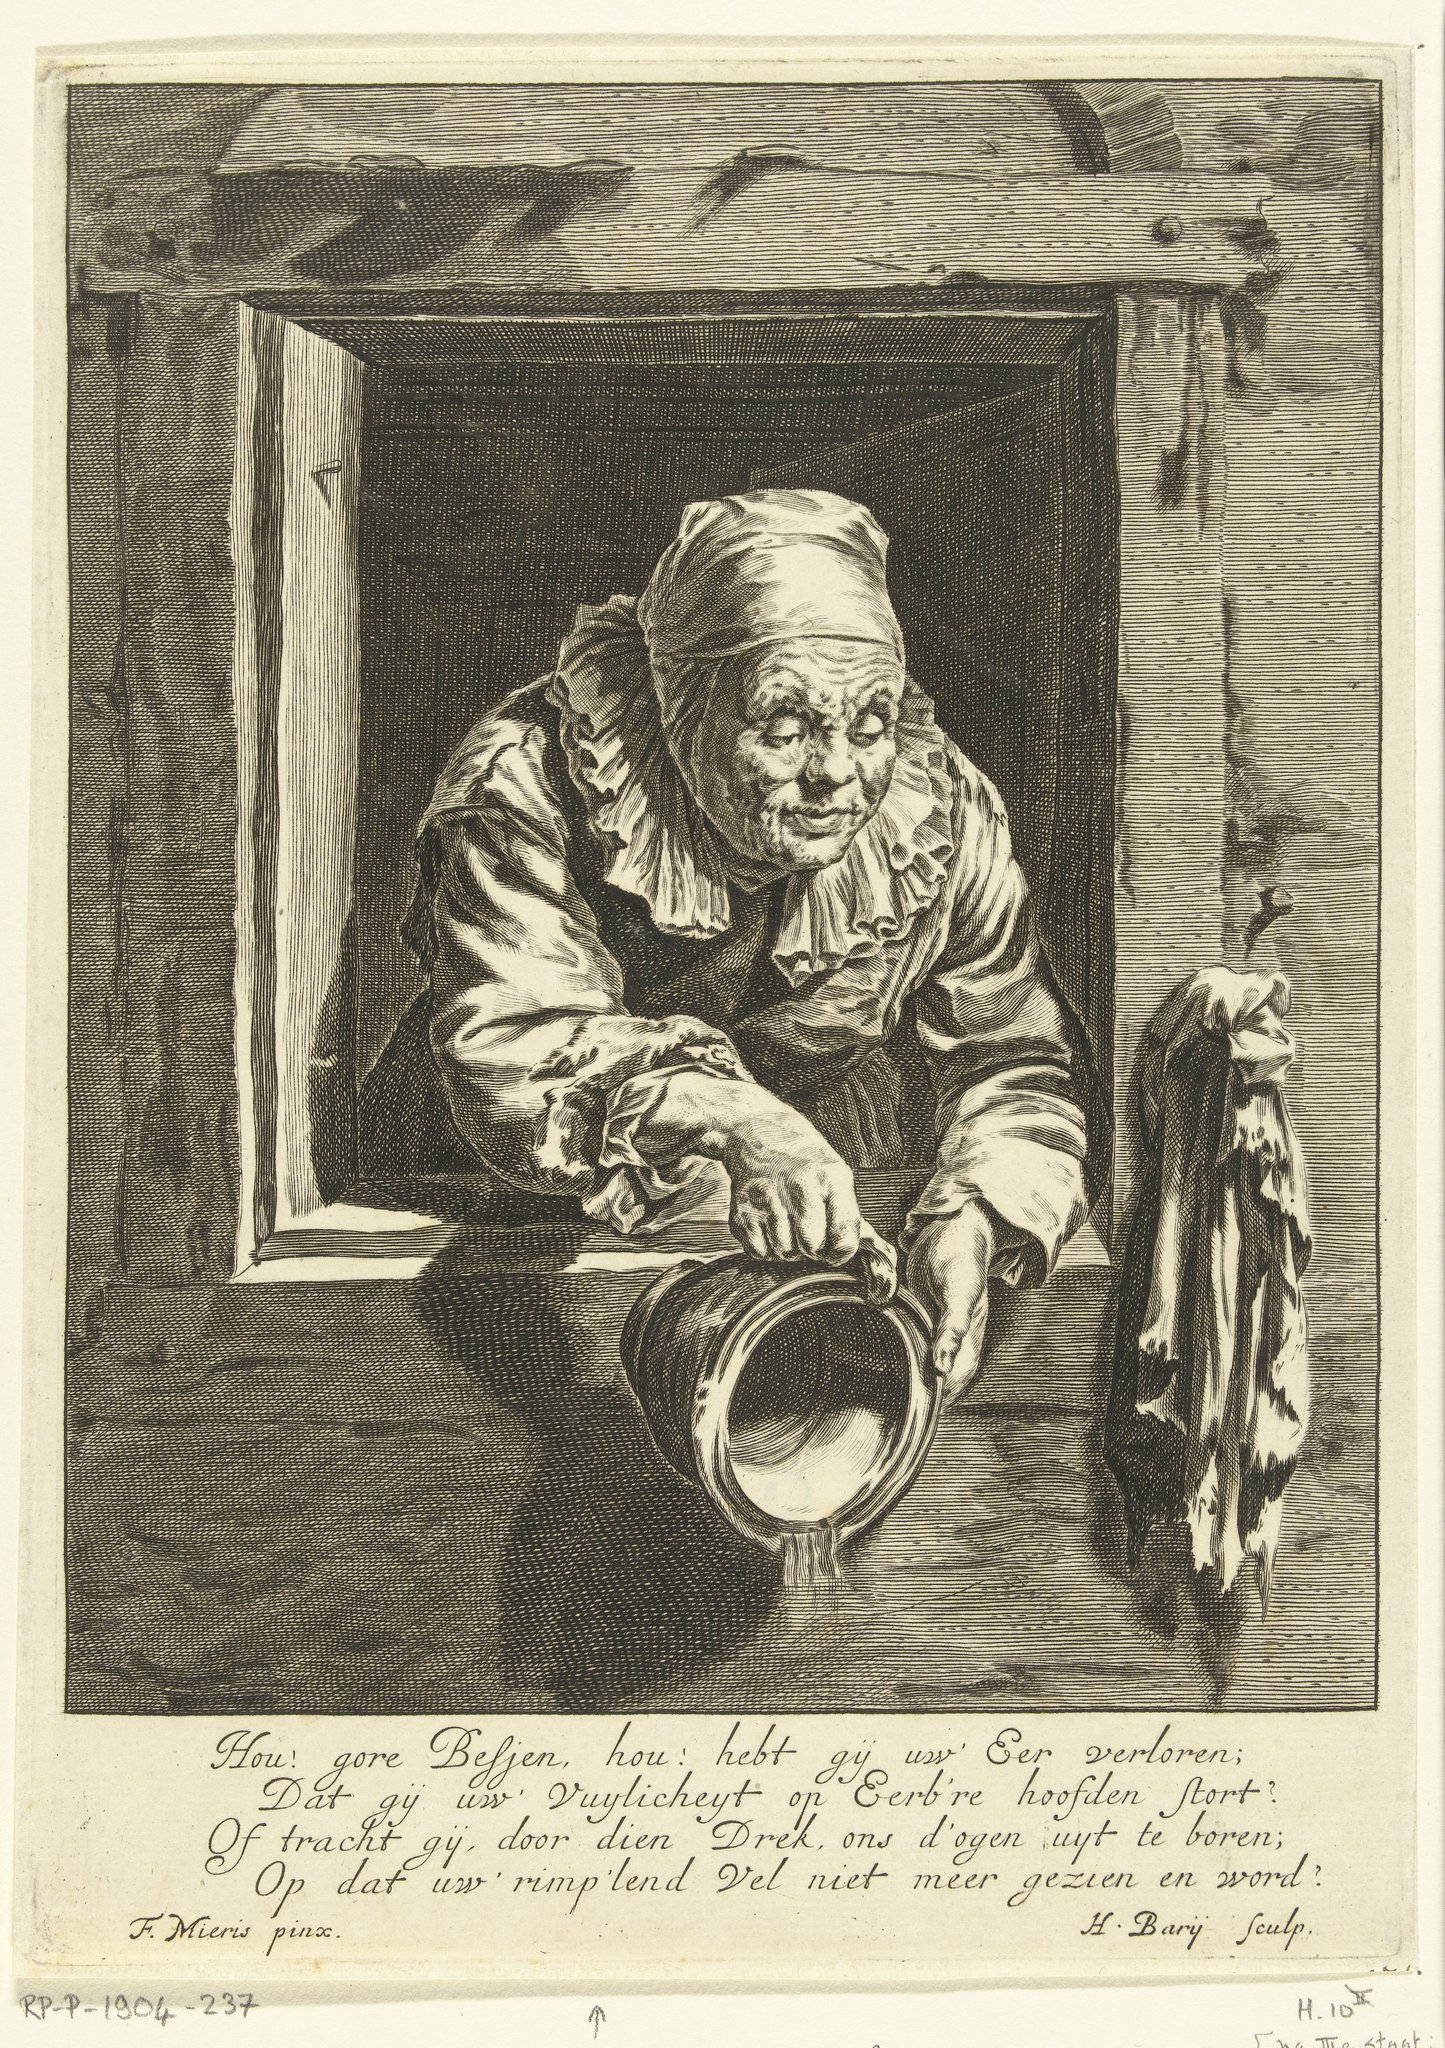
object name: print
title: Gore Besje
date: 1657-1707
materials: paper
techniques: engraving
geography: netherlands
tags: old woman, chamber-pot, chamber-pot is emptied from above ~ chasing away (unwanted) lover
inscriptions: collector's mark: Lugt 2228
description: Een oude vrouw gooit de inhoud van haar pispot uit het raam. Onder de voorstelling een vers van vier regels in het Nederlands.